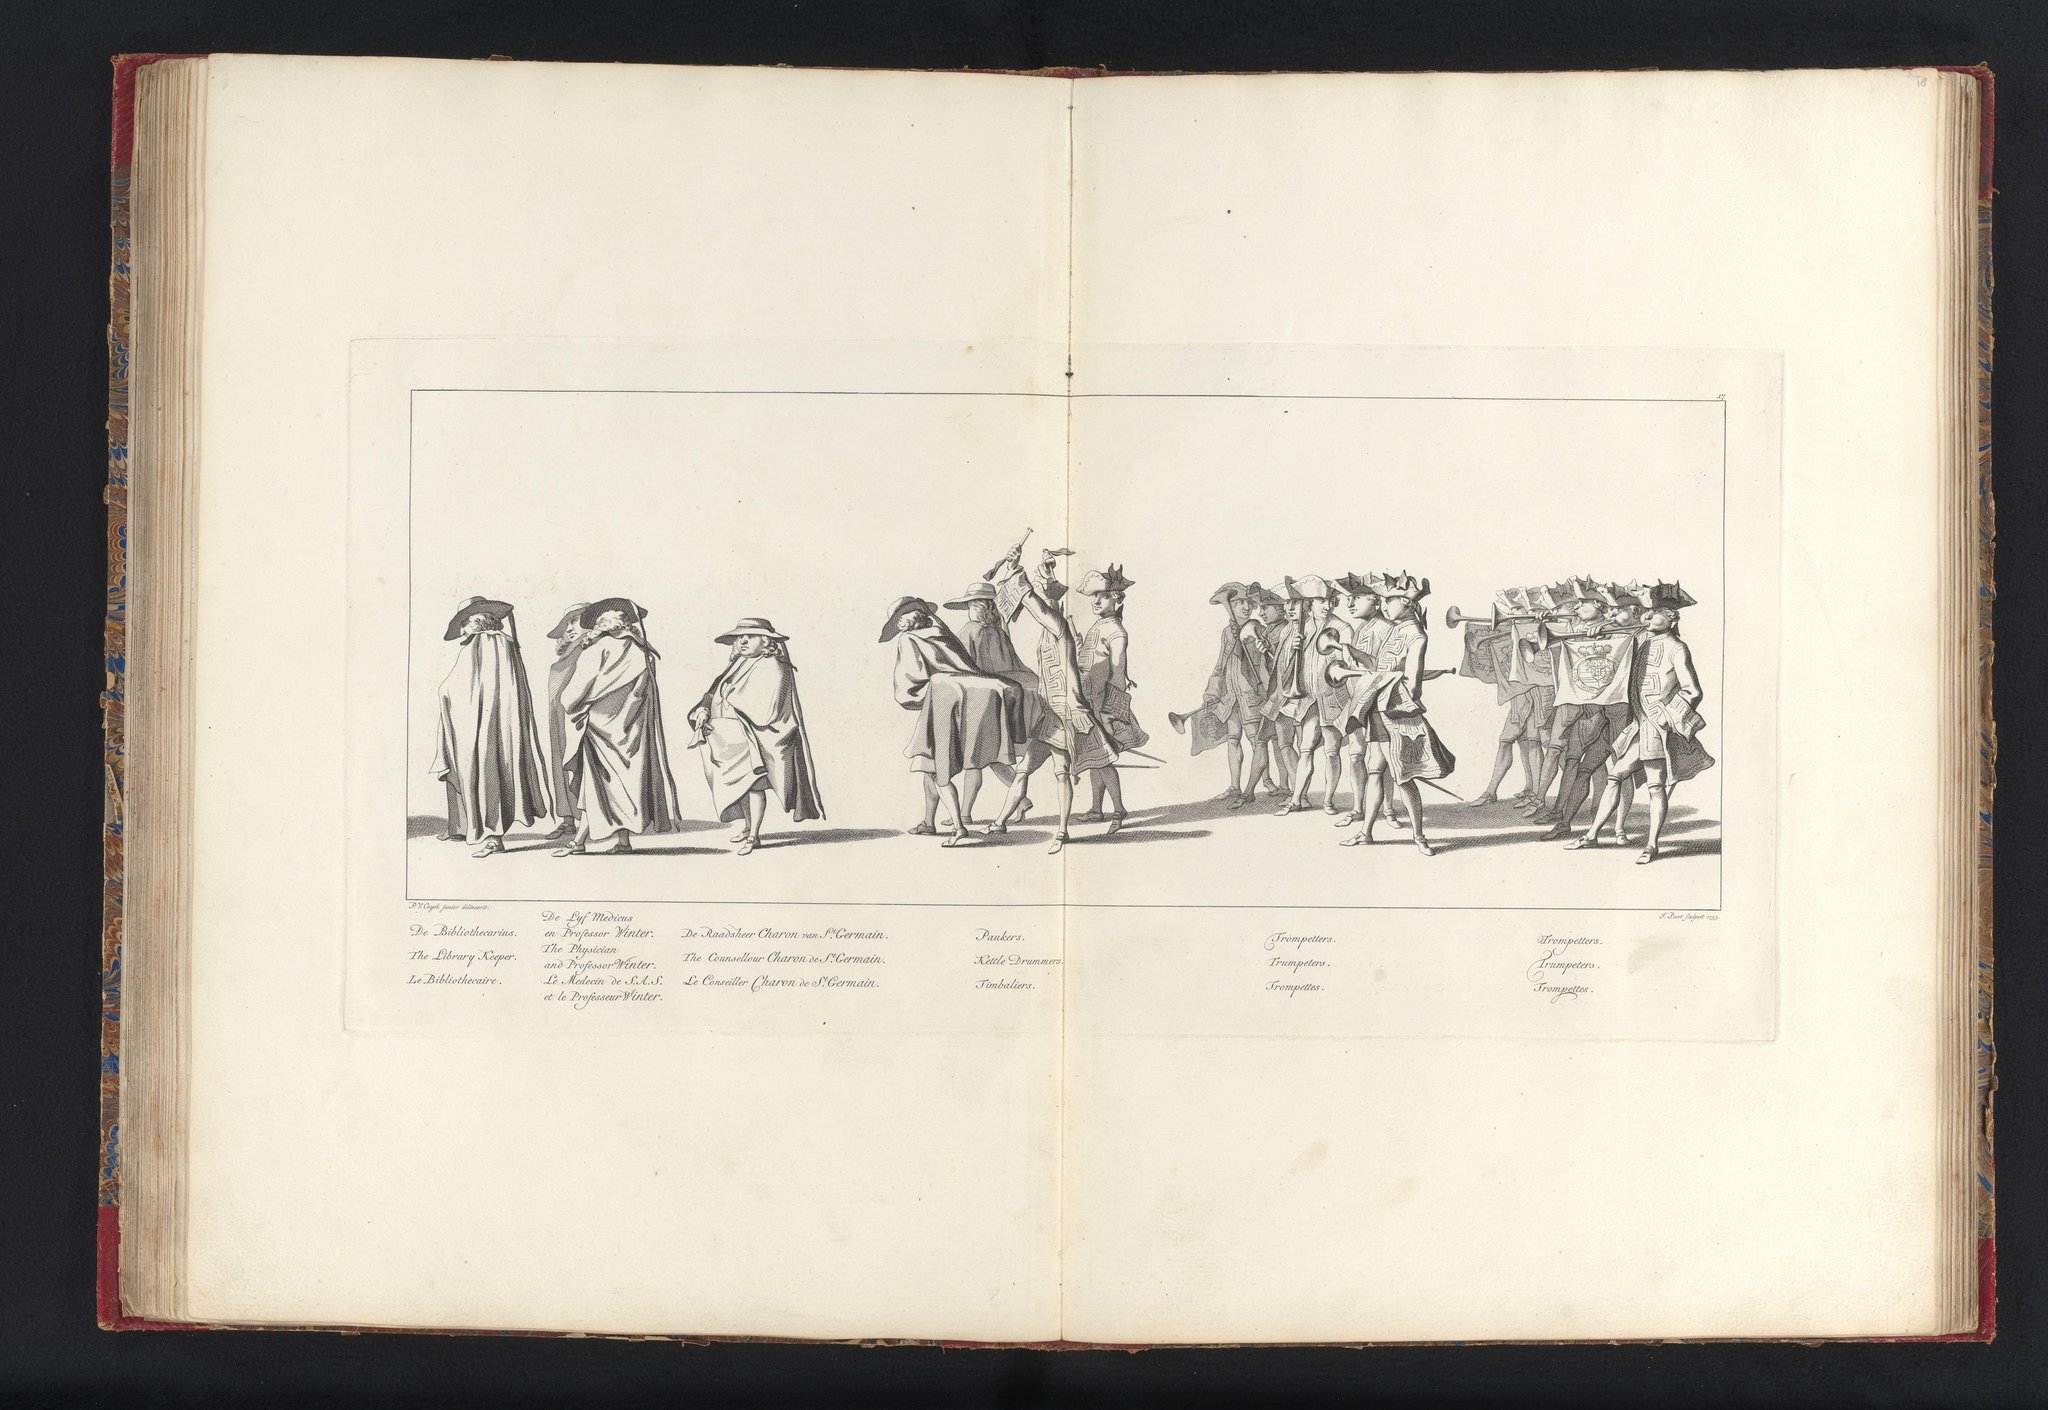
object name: print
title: Lyk-staetsie van zyne doorluchtigste Hoogheid den Heere Willem Carel Hendrik Friso, Prince van Orange en Nassau (...) gehouden den IV Februari 1752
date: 1753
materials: paper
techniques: engraving, etching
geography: the hague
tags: the hague, willem iv (prins van oranje-nassau), public library (+ scholar, scientist in non-work situations), military music, cortege, funeral procession, royal household; courtiers, retinue, train, delft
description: Leden van de stadhouderlijke hofhouding, waaronder de bibliothecaris en lijfarts, gevolgd door trommelslagers en trompetters. In de marge een onderschrift in het Nederlands, Frans en Engels. De prent maakt deel uit van een album.